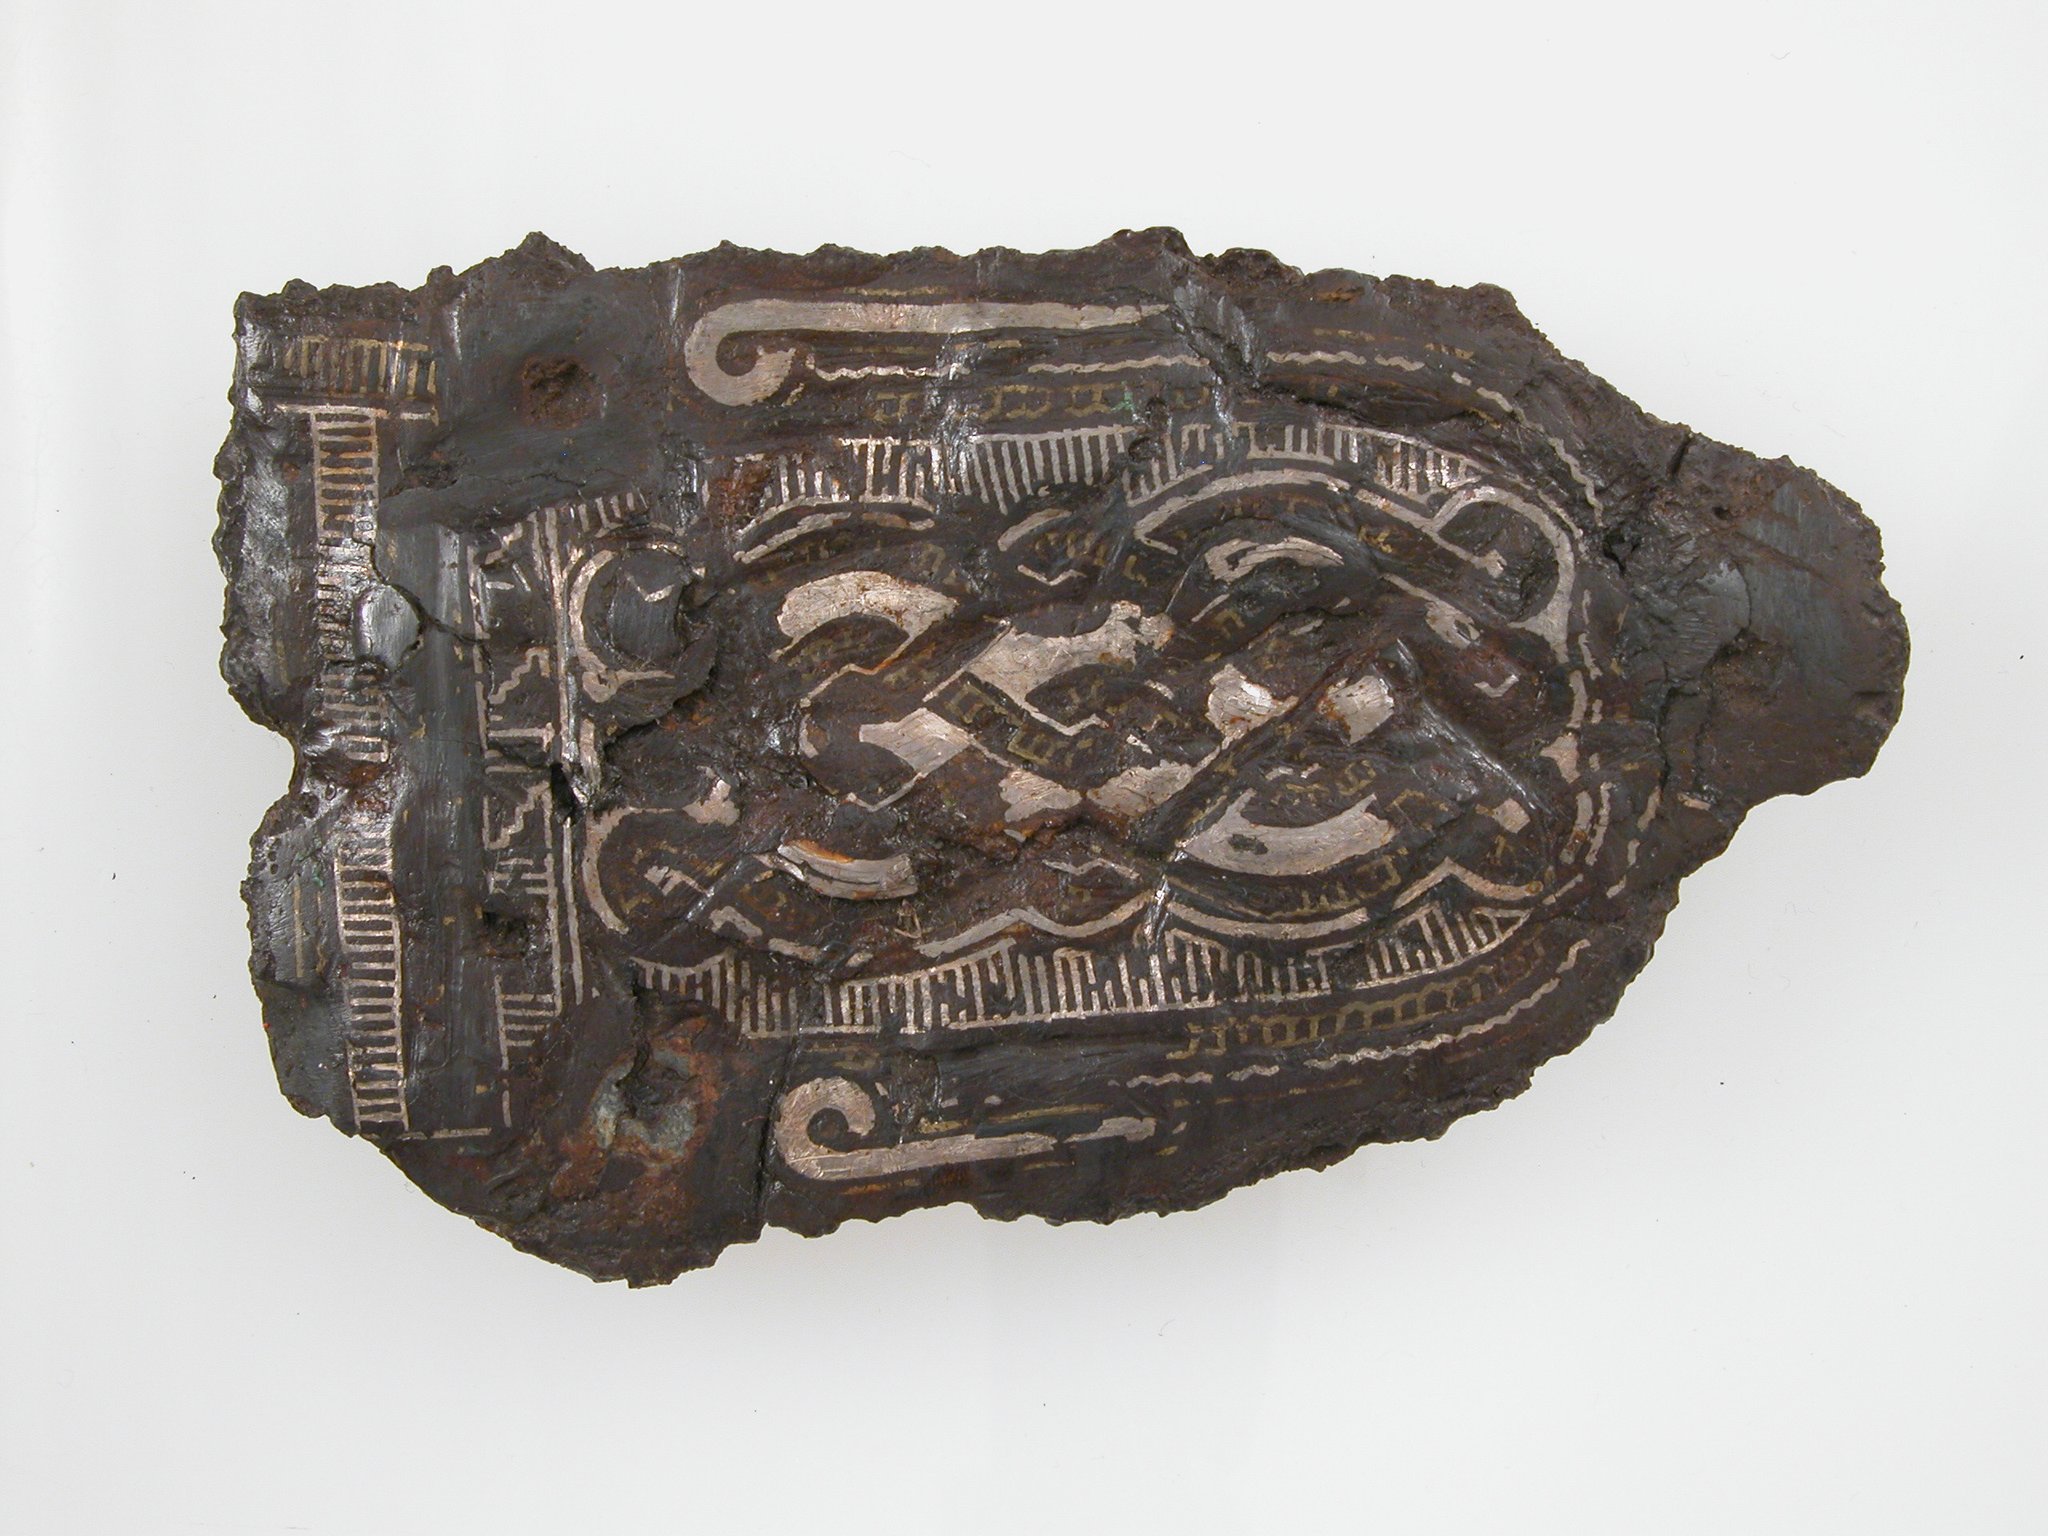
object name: belt plate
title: Counter Plate of a Belt Buckle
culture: frankish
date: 601-700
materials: brass, iron, silver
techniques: inlay